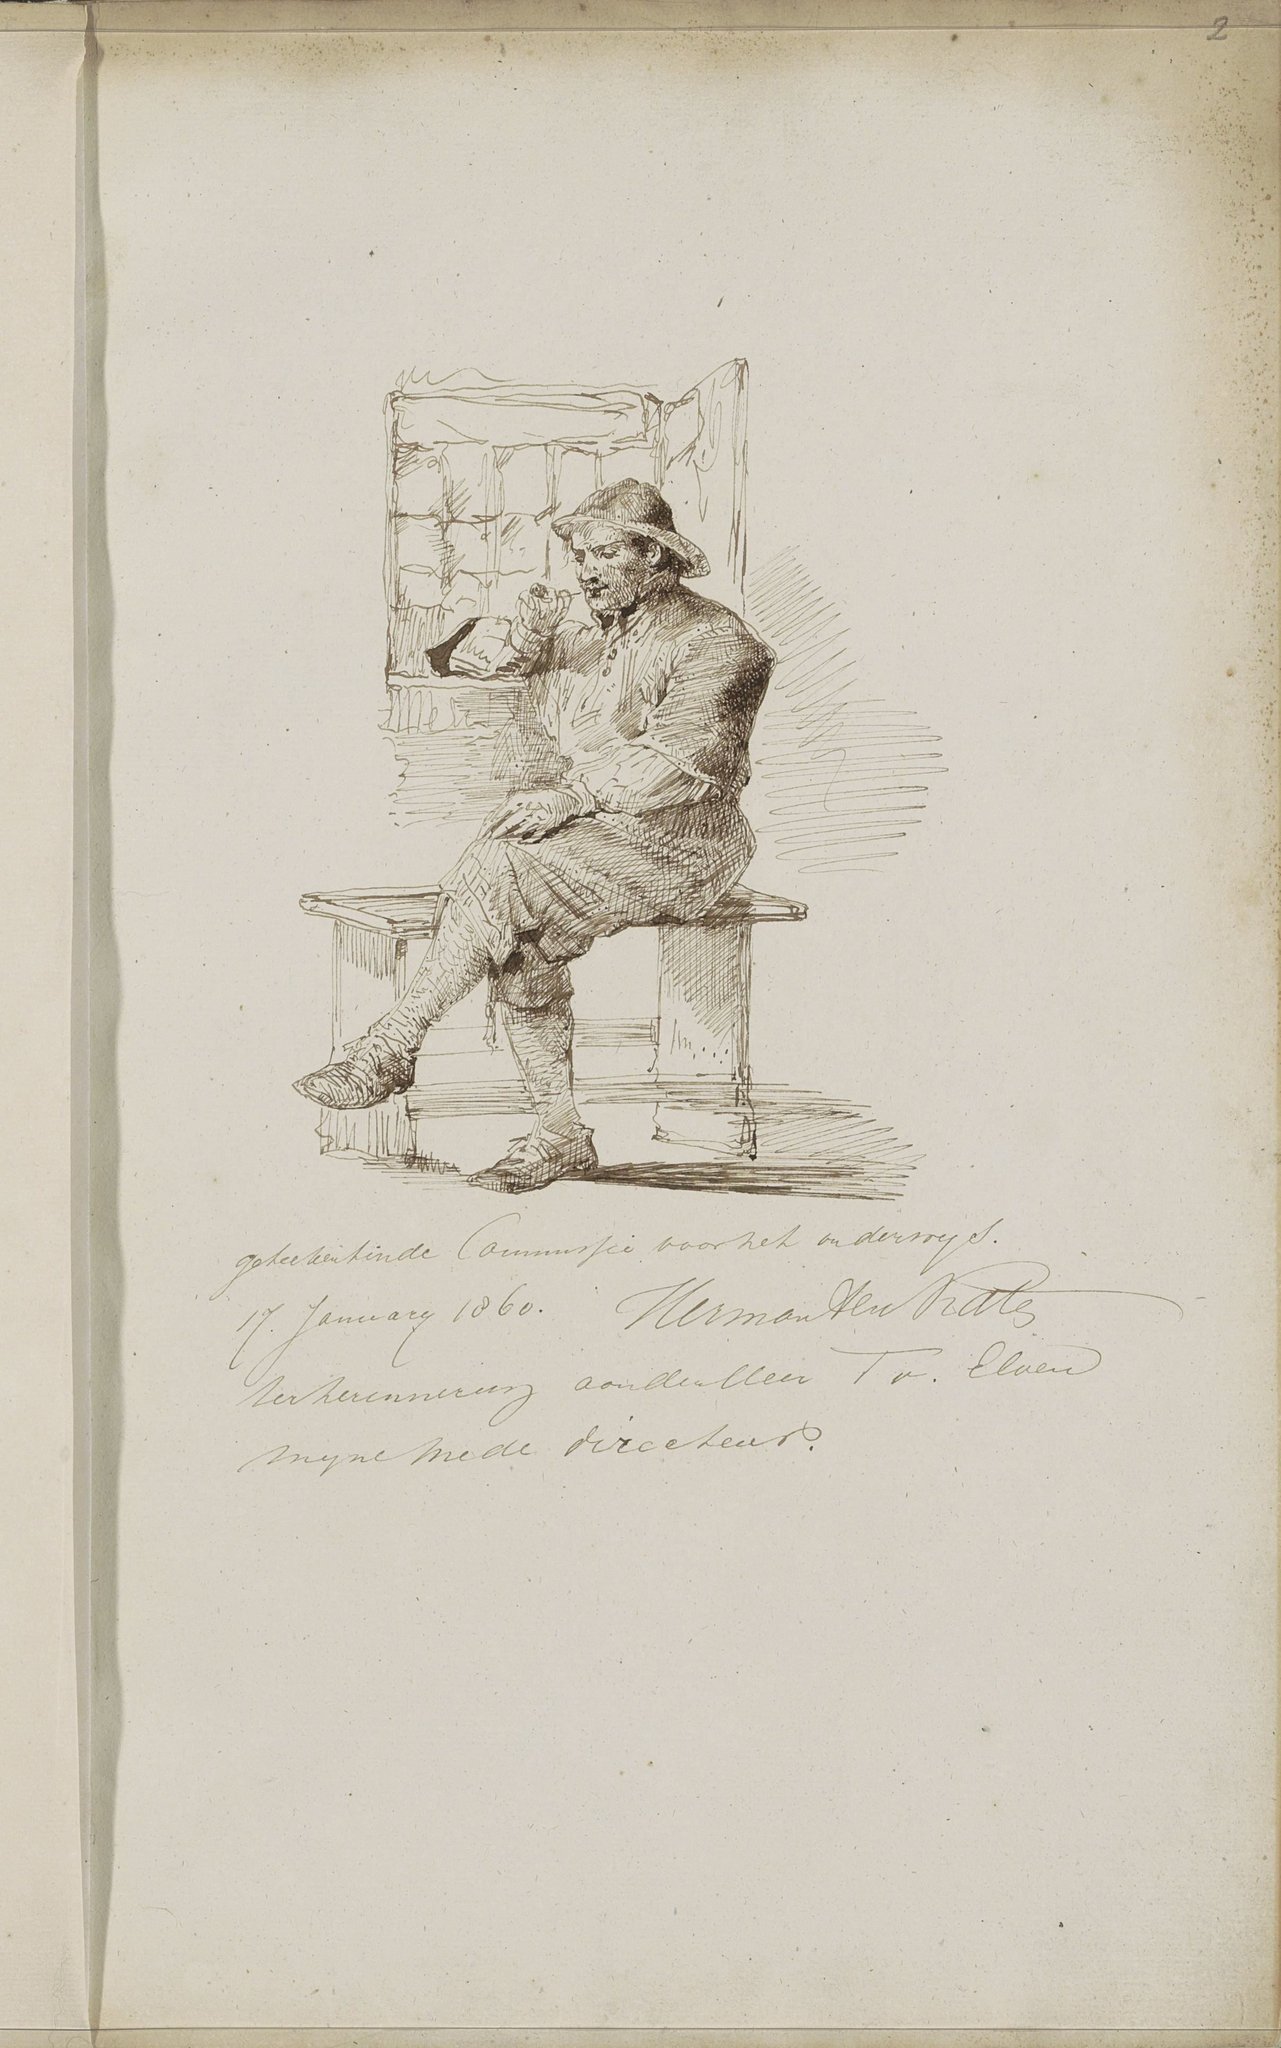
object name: album leaf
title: Pijprokende man bij een open venster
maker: herman frederik carel ten kate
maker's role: draughtsman, painter, print maker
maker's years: 1822-1891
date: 1801-1860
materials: ink, paper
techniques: pen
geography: amsterdam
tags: sitting figure, pipe ~ tobacco, open window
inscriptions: date and inscription: ‘geteekent in de Commissie voor het onderwijs./ 17 January 1860. Herman ten Kate/ ter herinnering aan den Heer T v. Elven/ mijne mede directeur’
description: Blad 2 recto uit een verzamelalbum met 32 bladen.